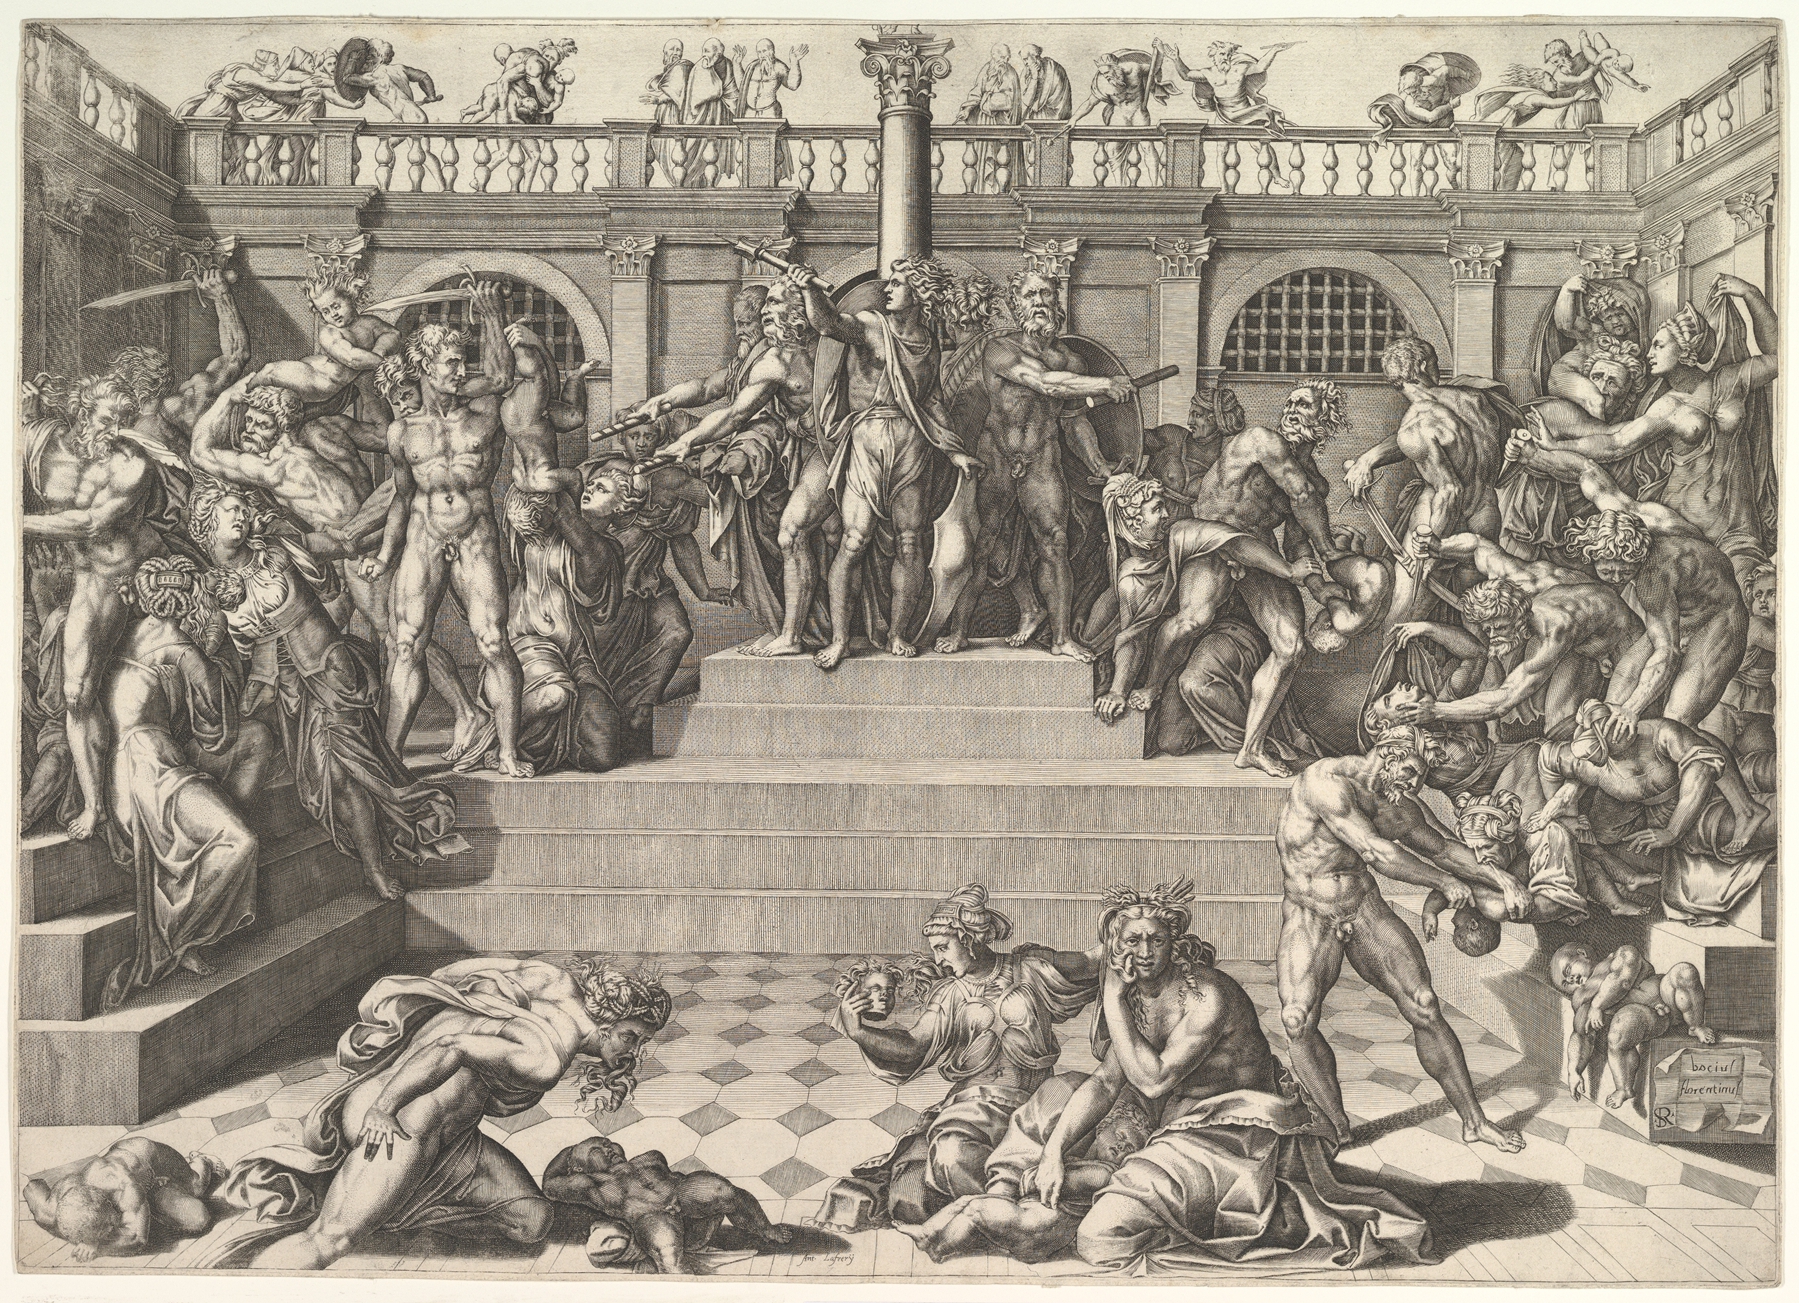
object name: print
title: Massacre of the Innocents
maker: baccio bandinelli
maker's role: artist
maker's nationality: italian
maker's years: 1493-1560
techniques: engraving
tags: massacres,children,male nudes,women